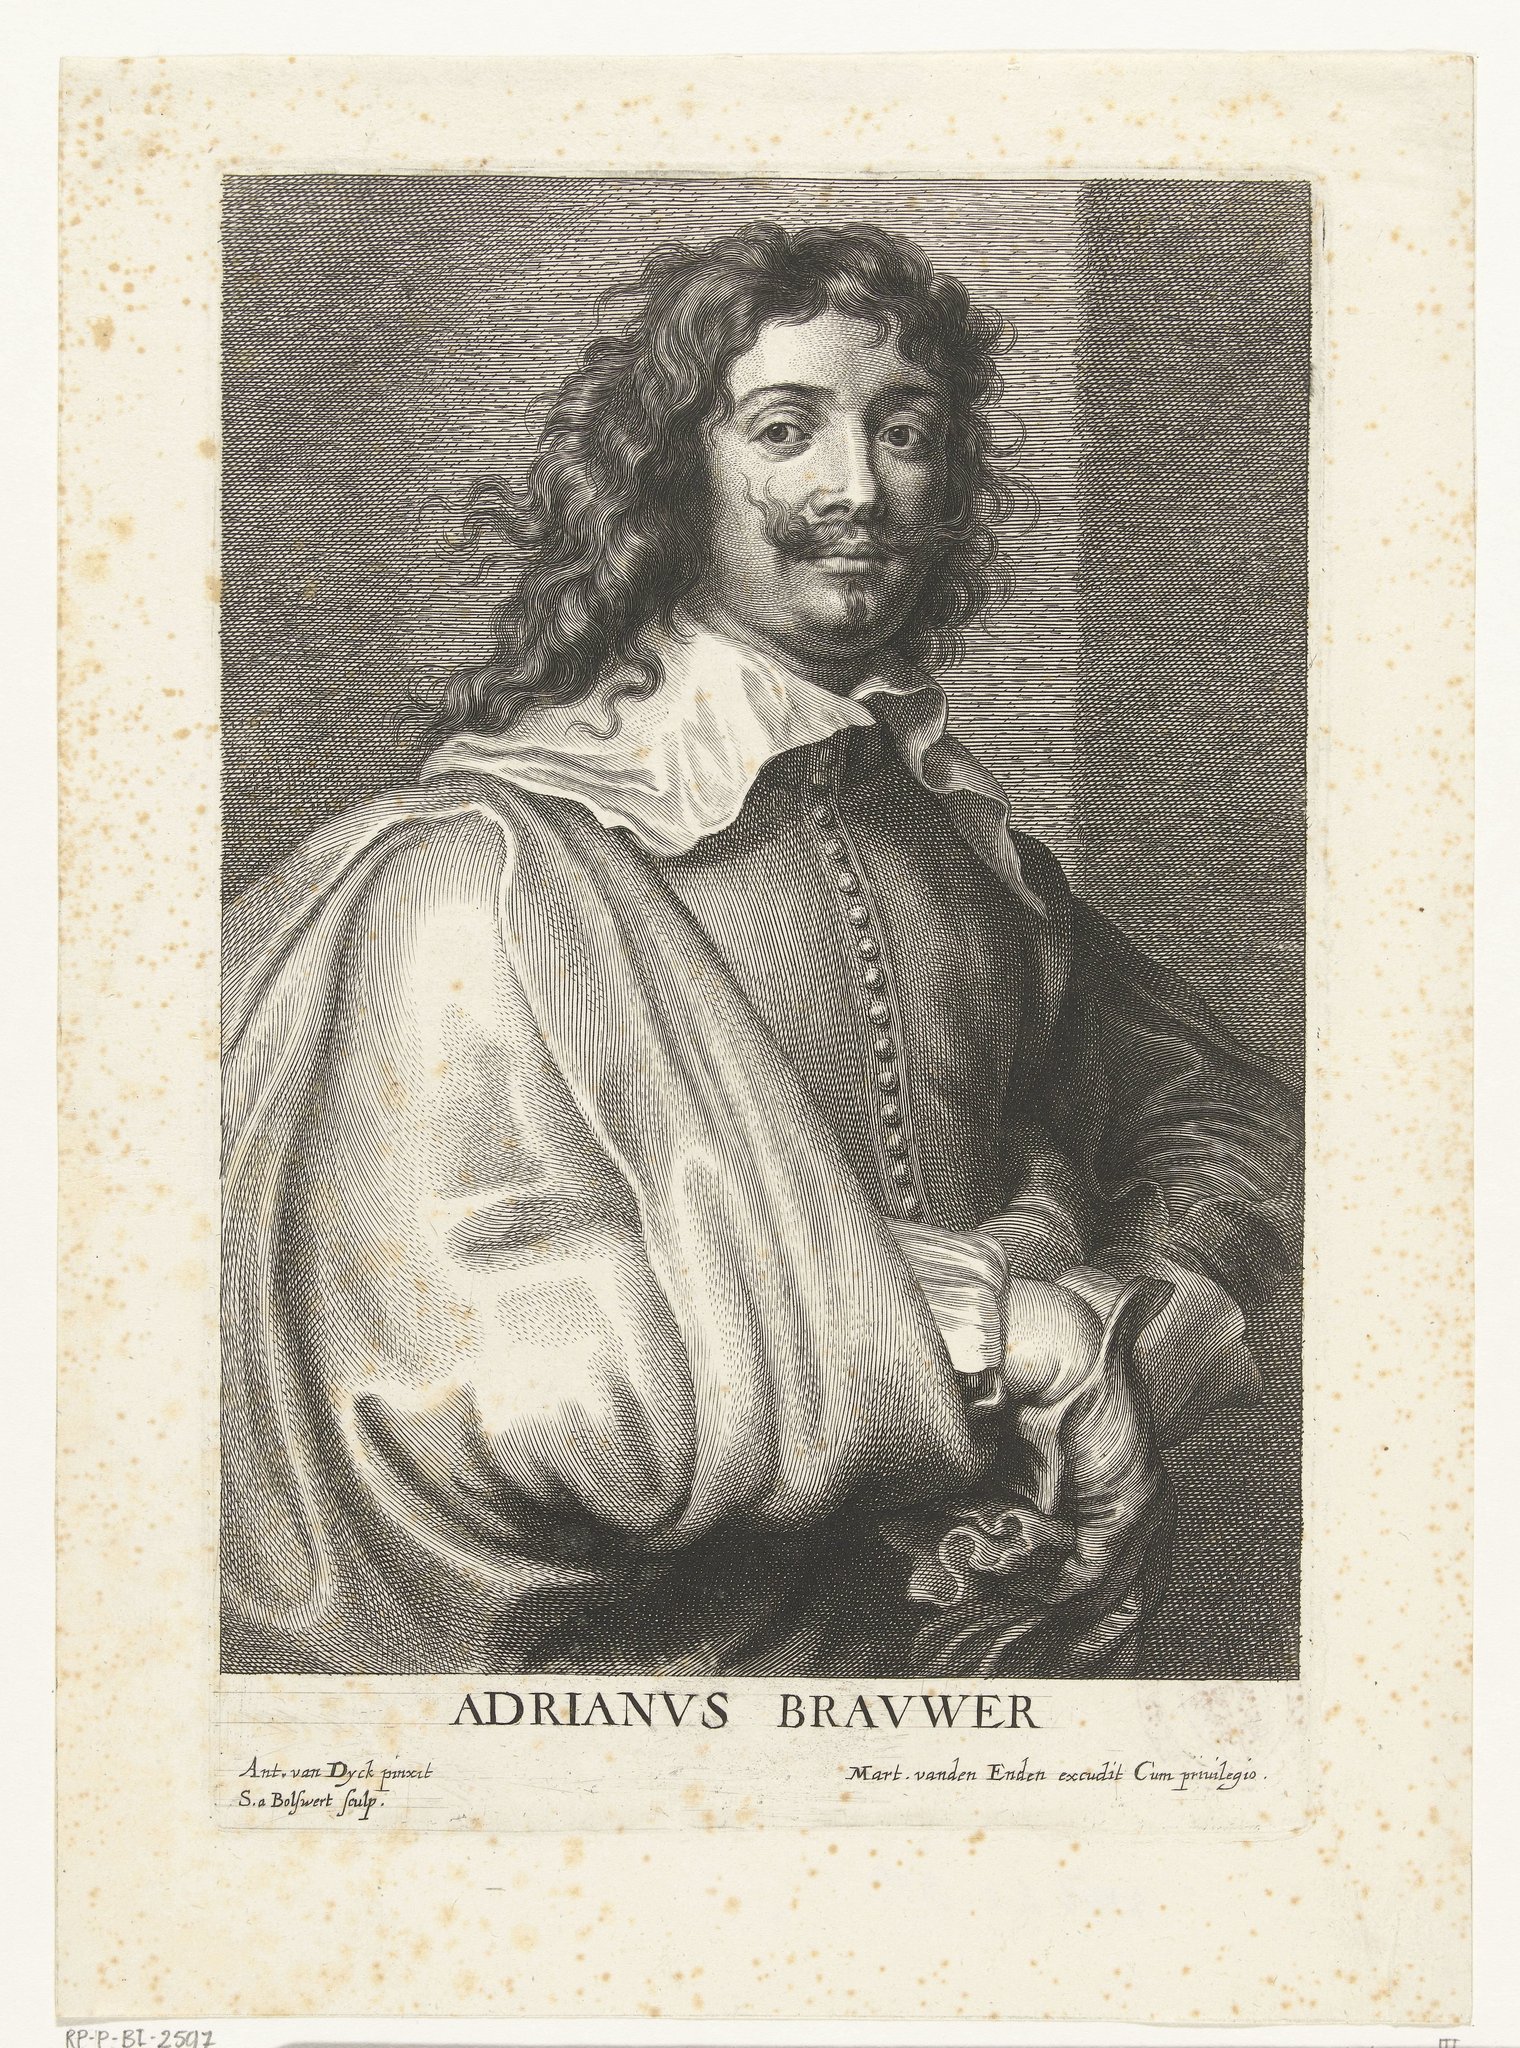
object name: print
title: Portret van schilder Adriaen Brouwer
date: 1596-1659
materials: paper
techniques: engraving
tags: antwerp, painter, draughtsman, adriaen brouwer, portrait, self-portrait of painter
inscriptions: collector's mark: Lugt 240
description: Prent naar schilderij van Anthony van Dyck.